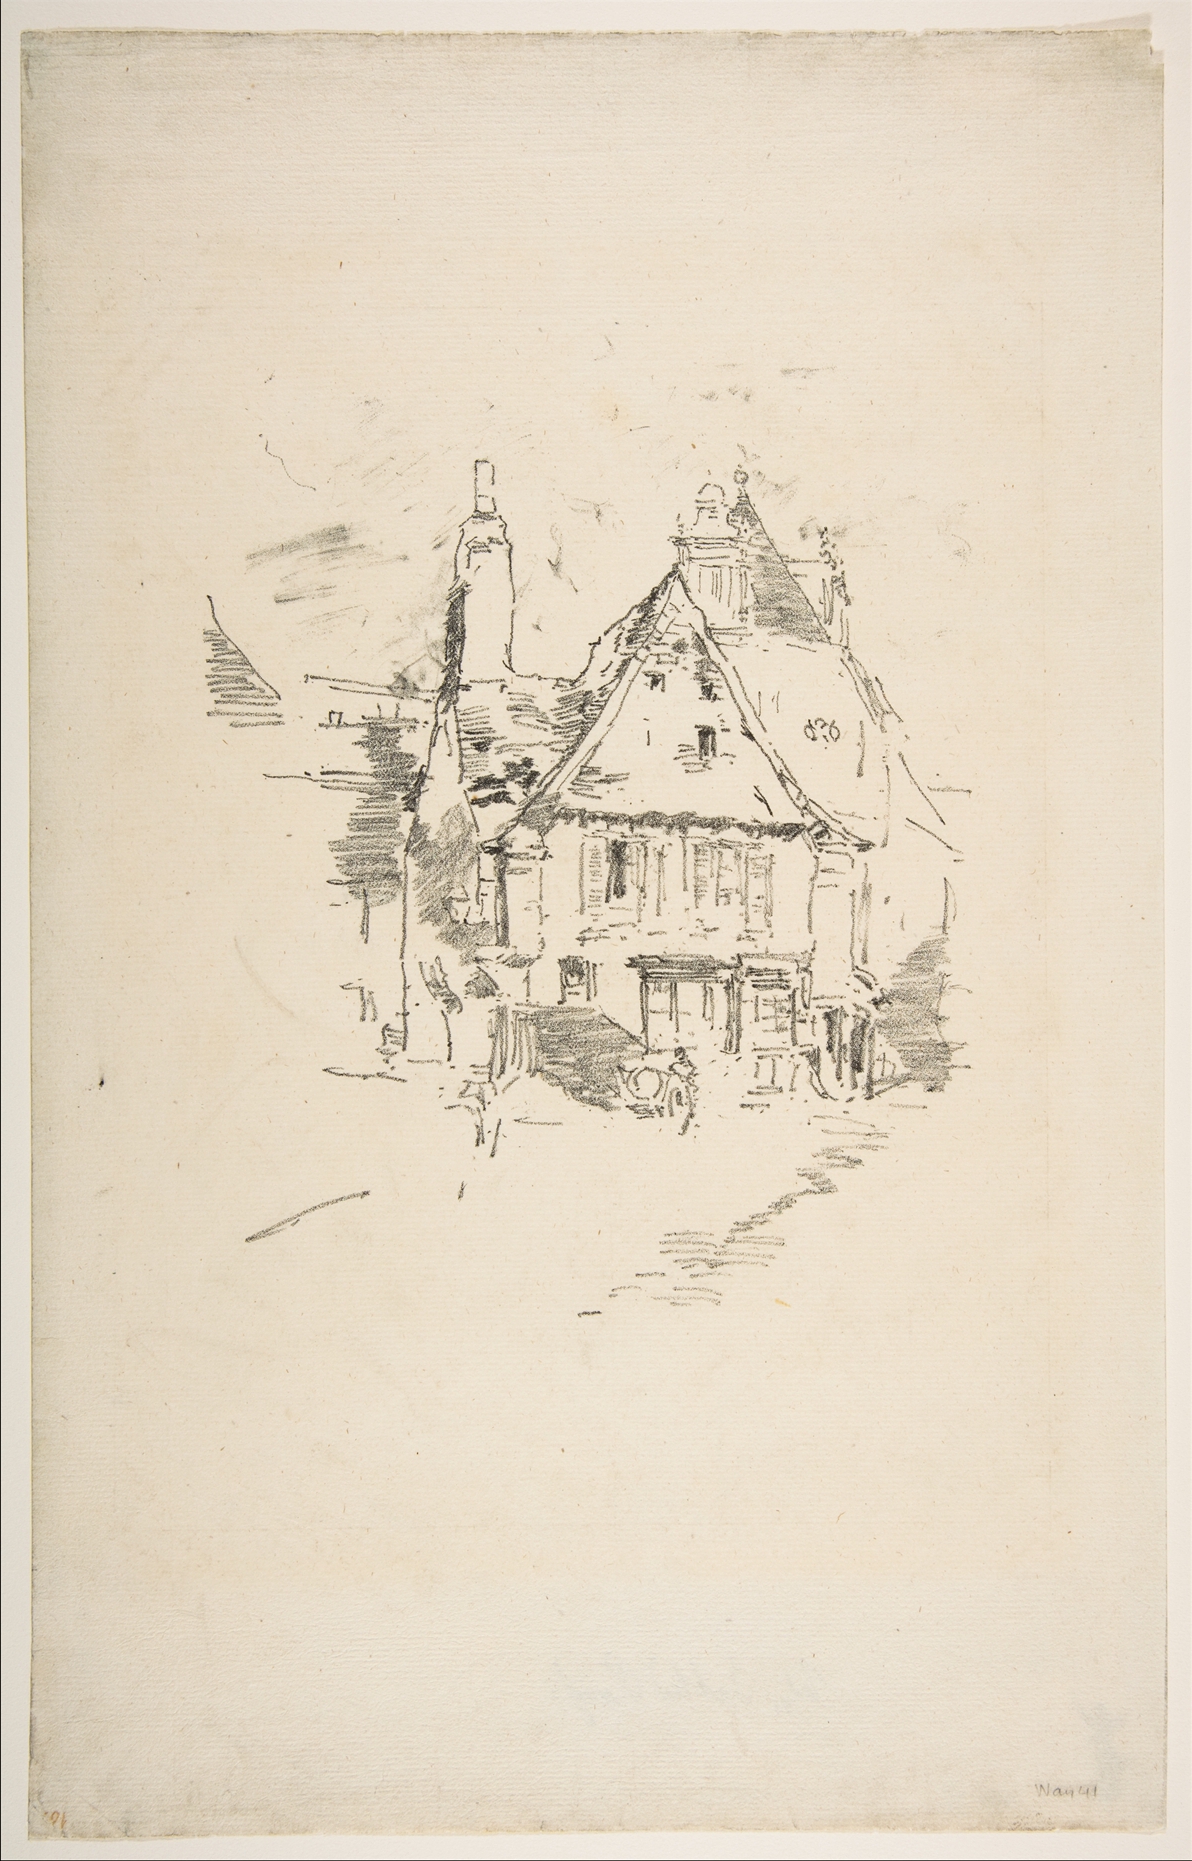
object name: print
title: Gabled Roofs (Gabled Roofs, Vitré)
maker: james mcneill whistler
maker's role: artist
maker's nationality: american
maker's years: 1834-1903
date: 1893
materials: ink, paper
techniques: printing, stumping, lithography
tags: buildings,roofs